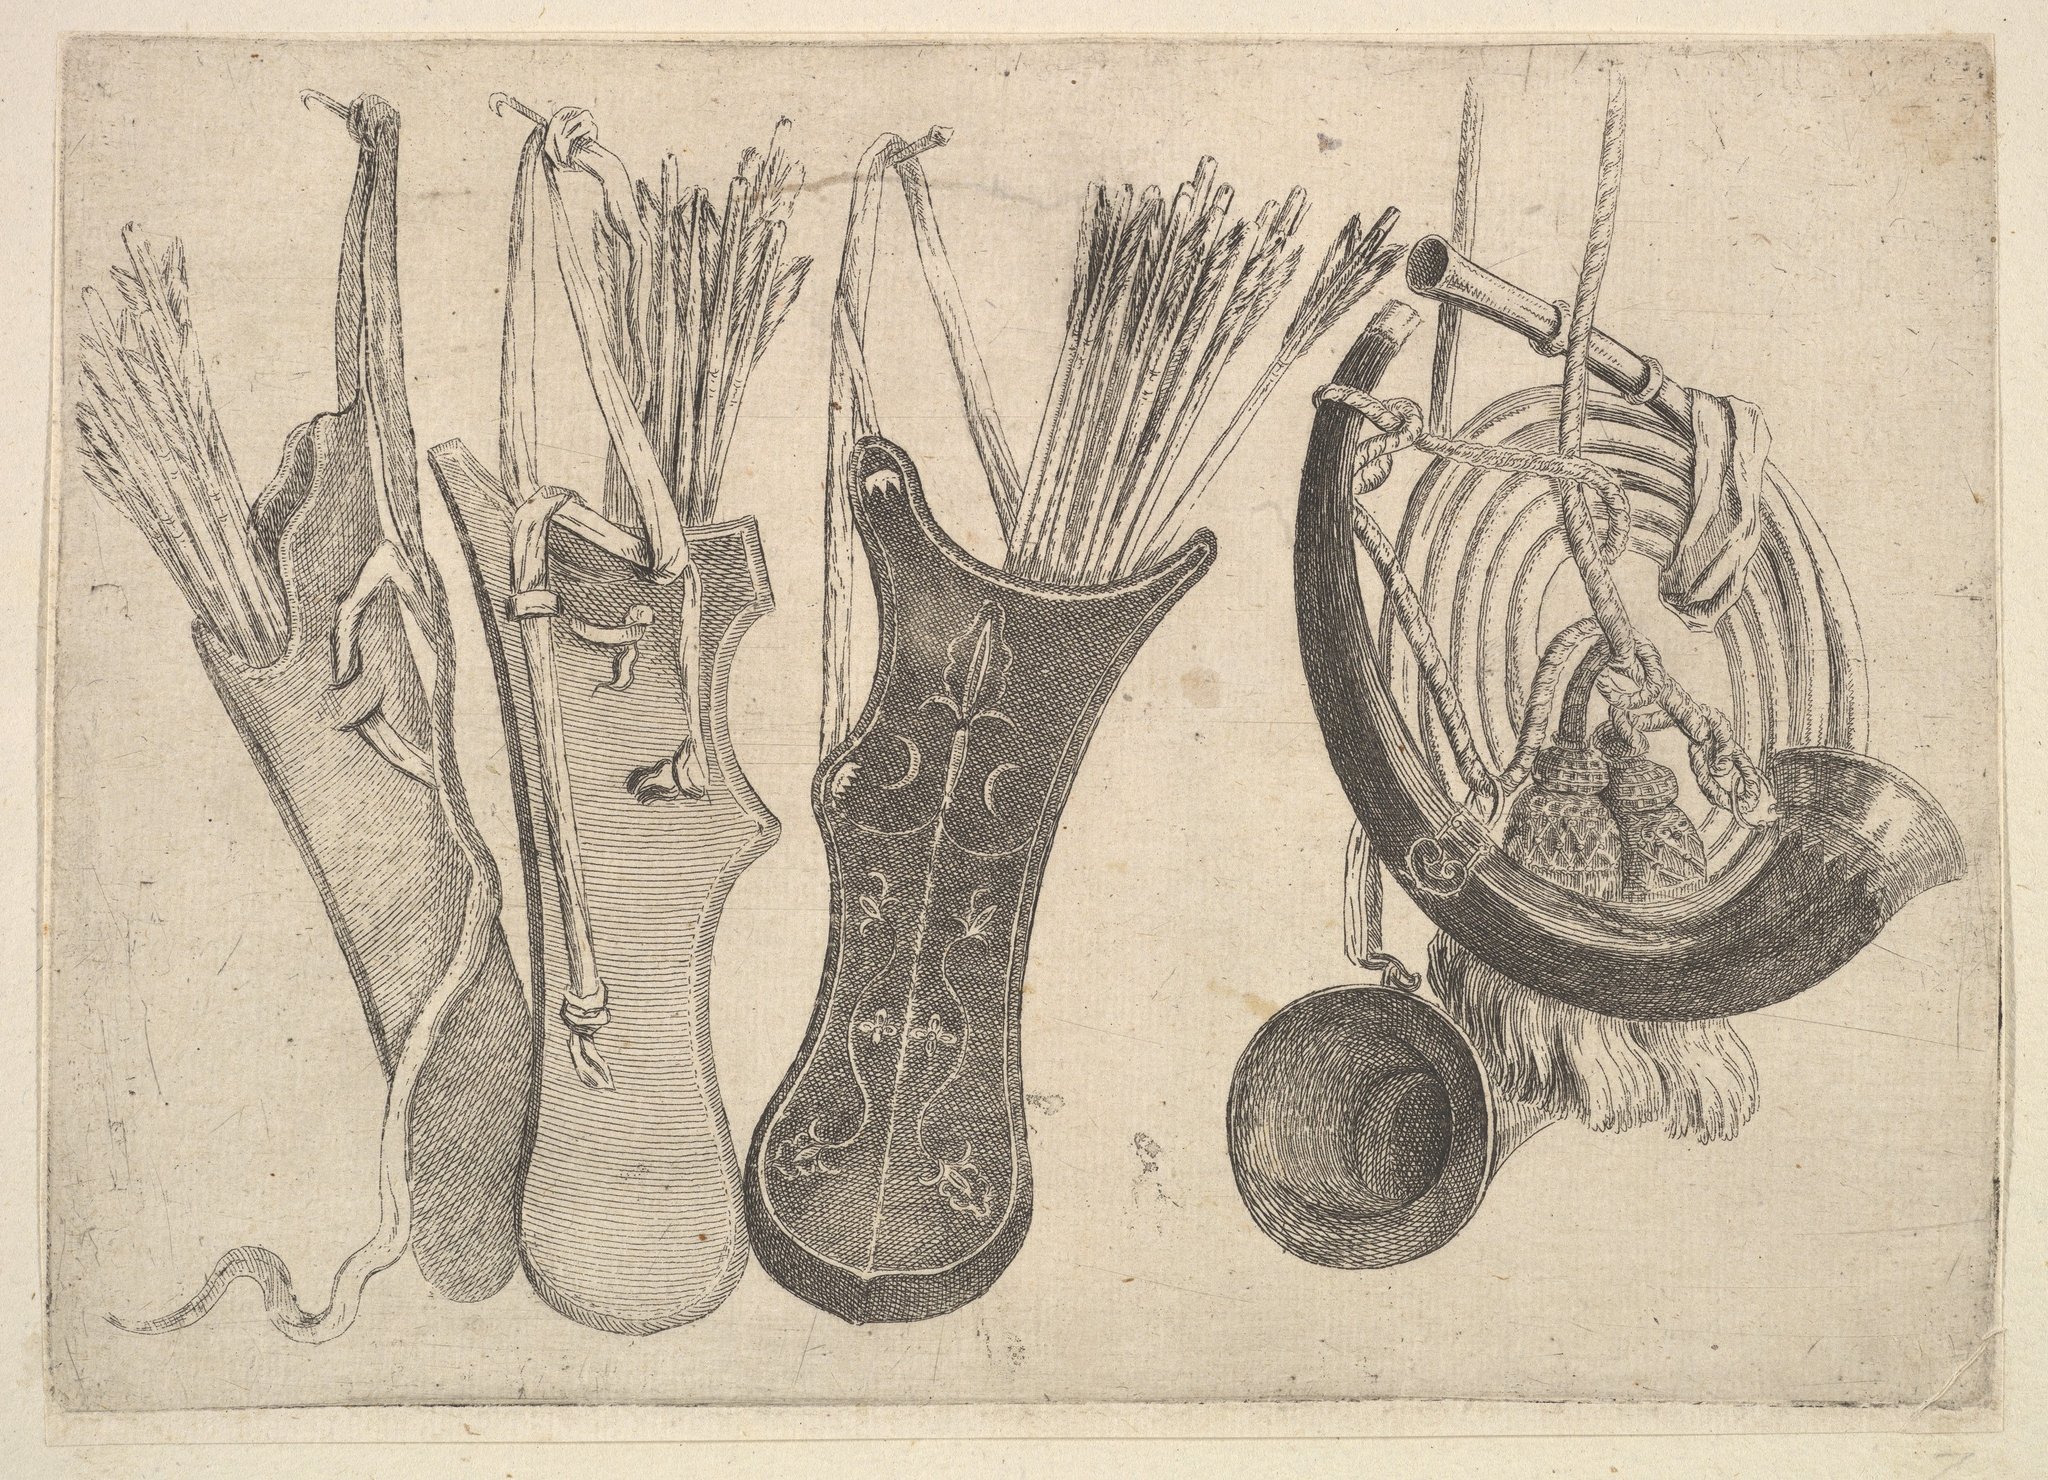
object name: print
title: Quivers and hunting horns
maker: wenceslaus hollar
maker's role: artist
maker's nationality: bohemian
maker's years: 1607-1677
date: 1647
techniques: etching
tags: arrows,horns